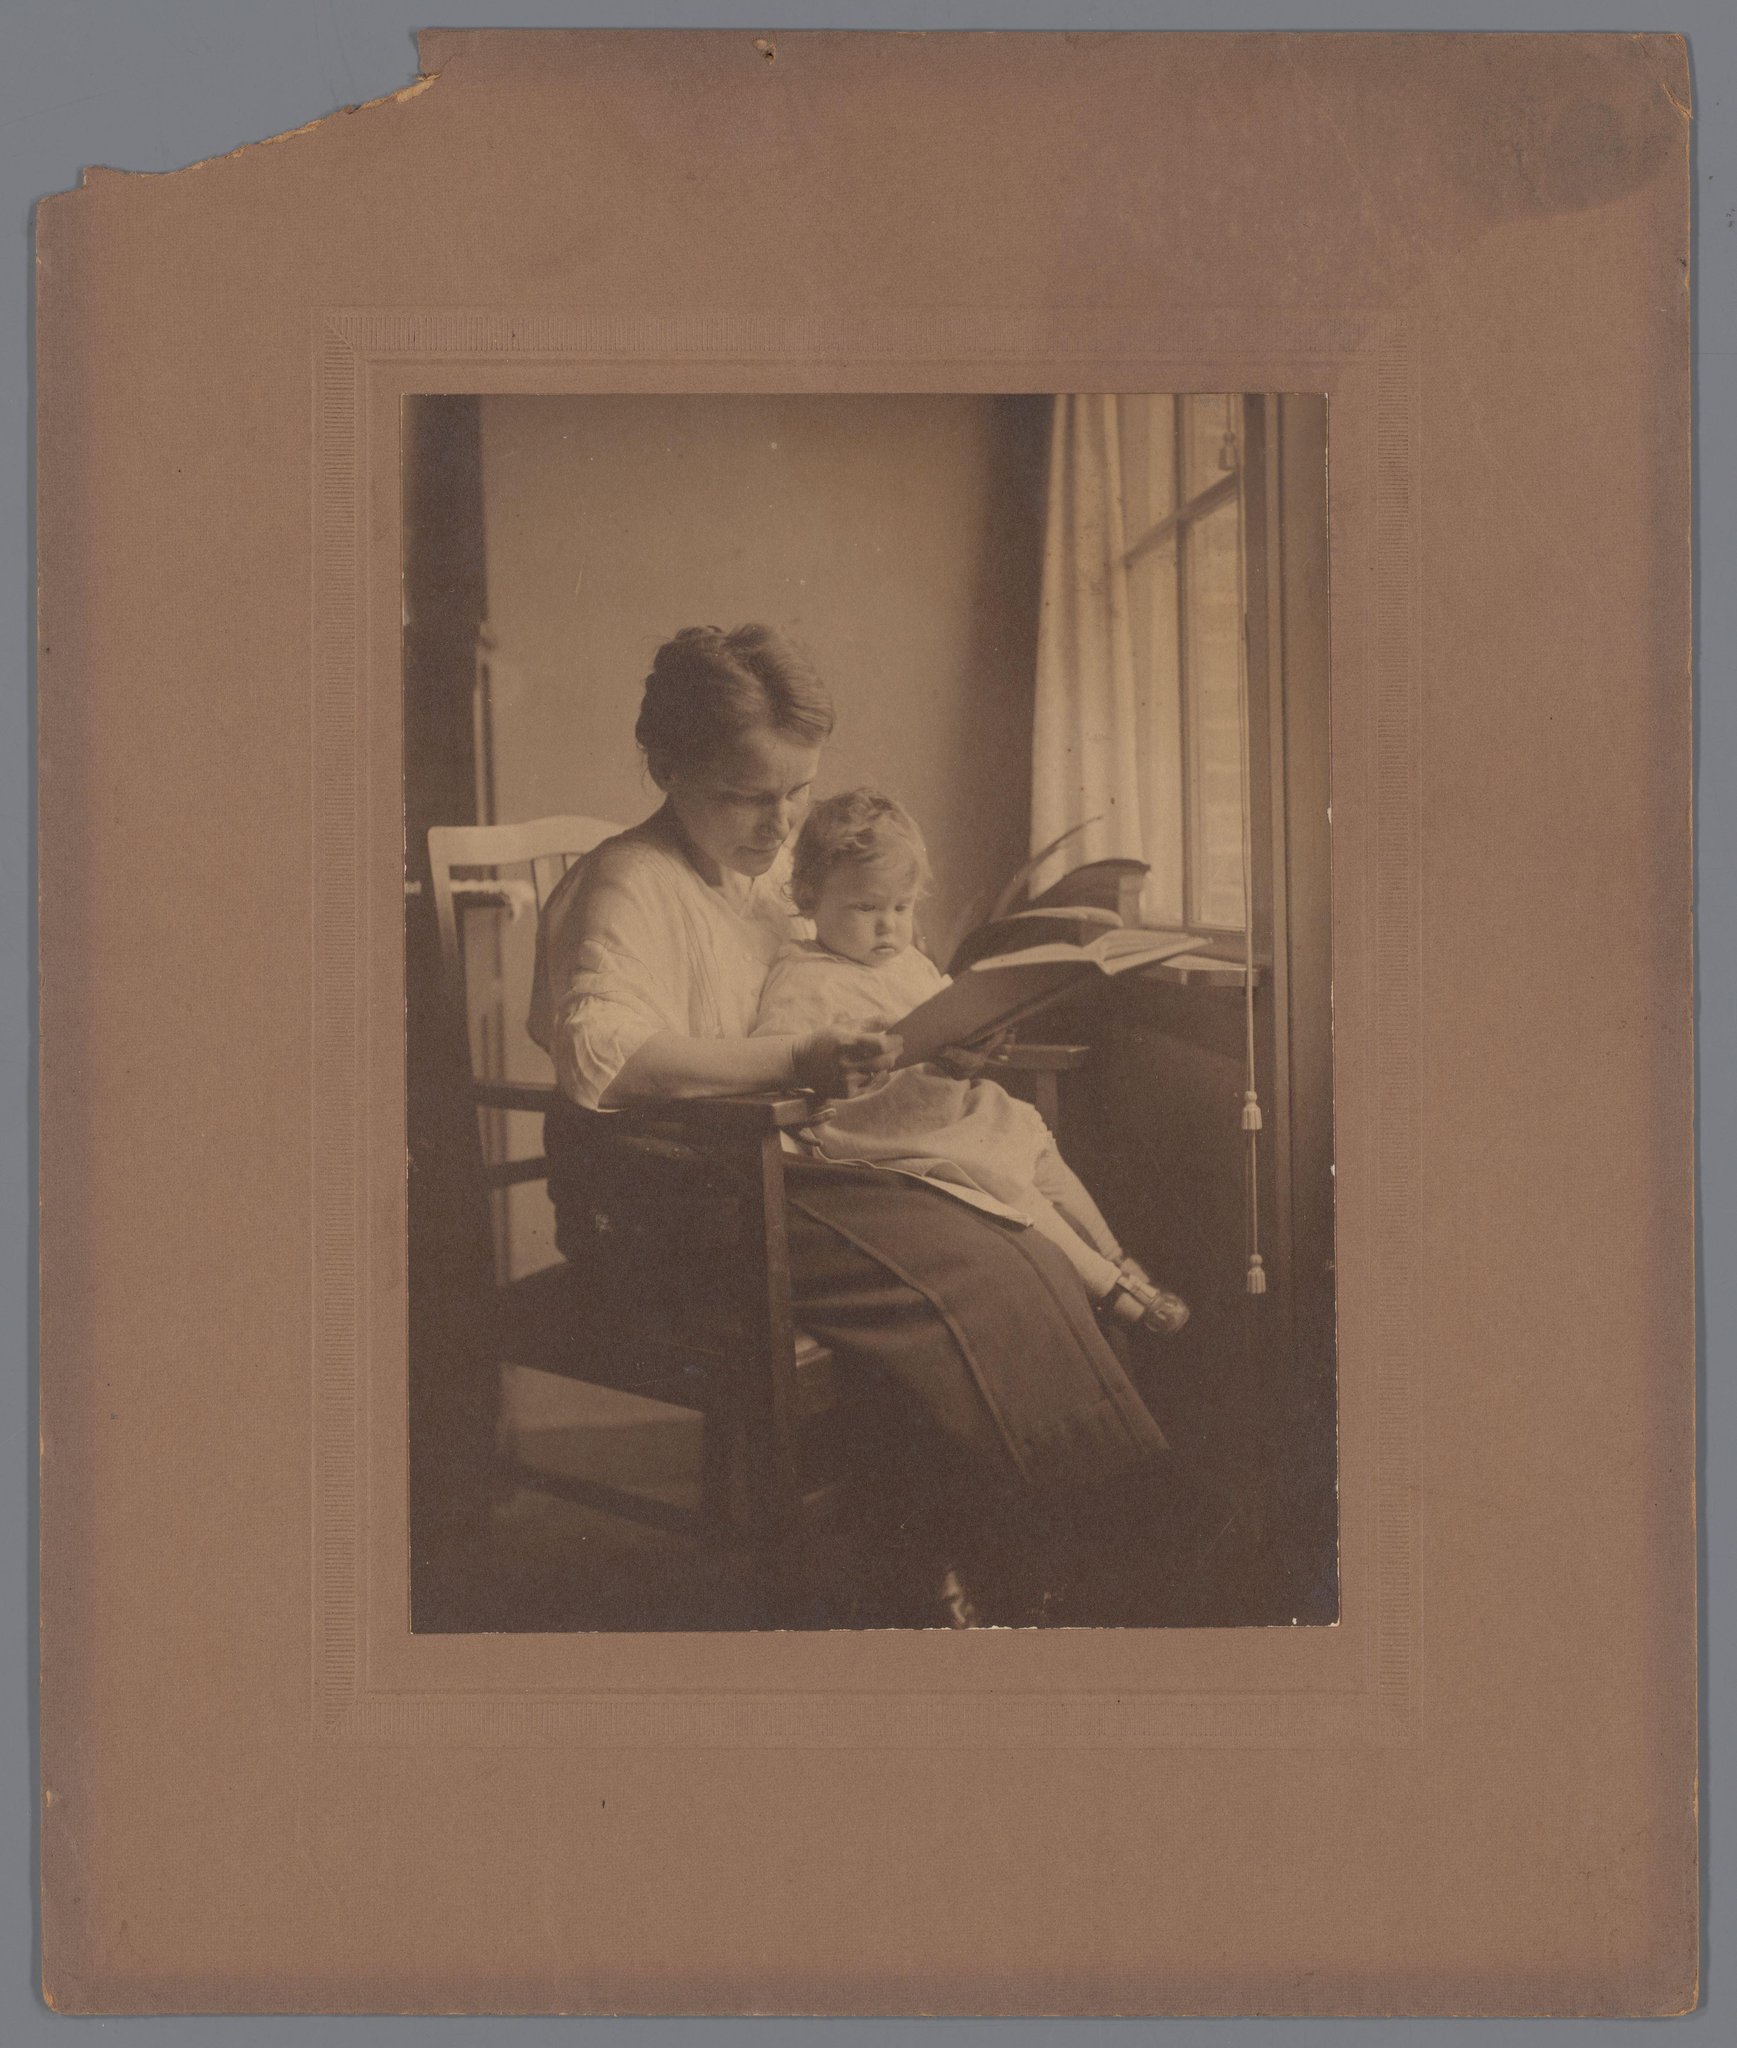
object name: photograph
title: Portret moeder met kind op schoot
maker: leonard vlaanderen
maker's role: fotograaf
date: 1900-1925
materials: cardboard, photographic support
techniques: gelatin silver print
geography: alkmaar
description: Portret moeder met kind op schoot. Vrouw in lange rok en witte blouse leest het kind voor, zittend op een stoel bij het raam.